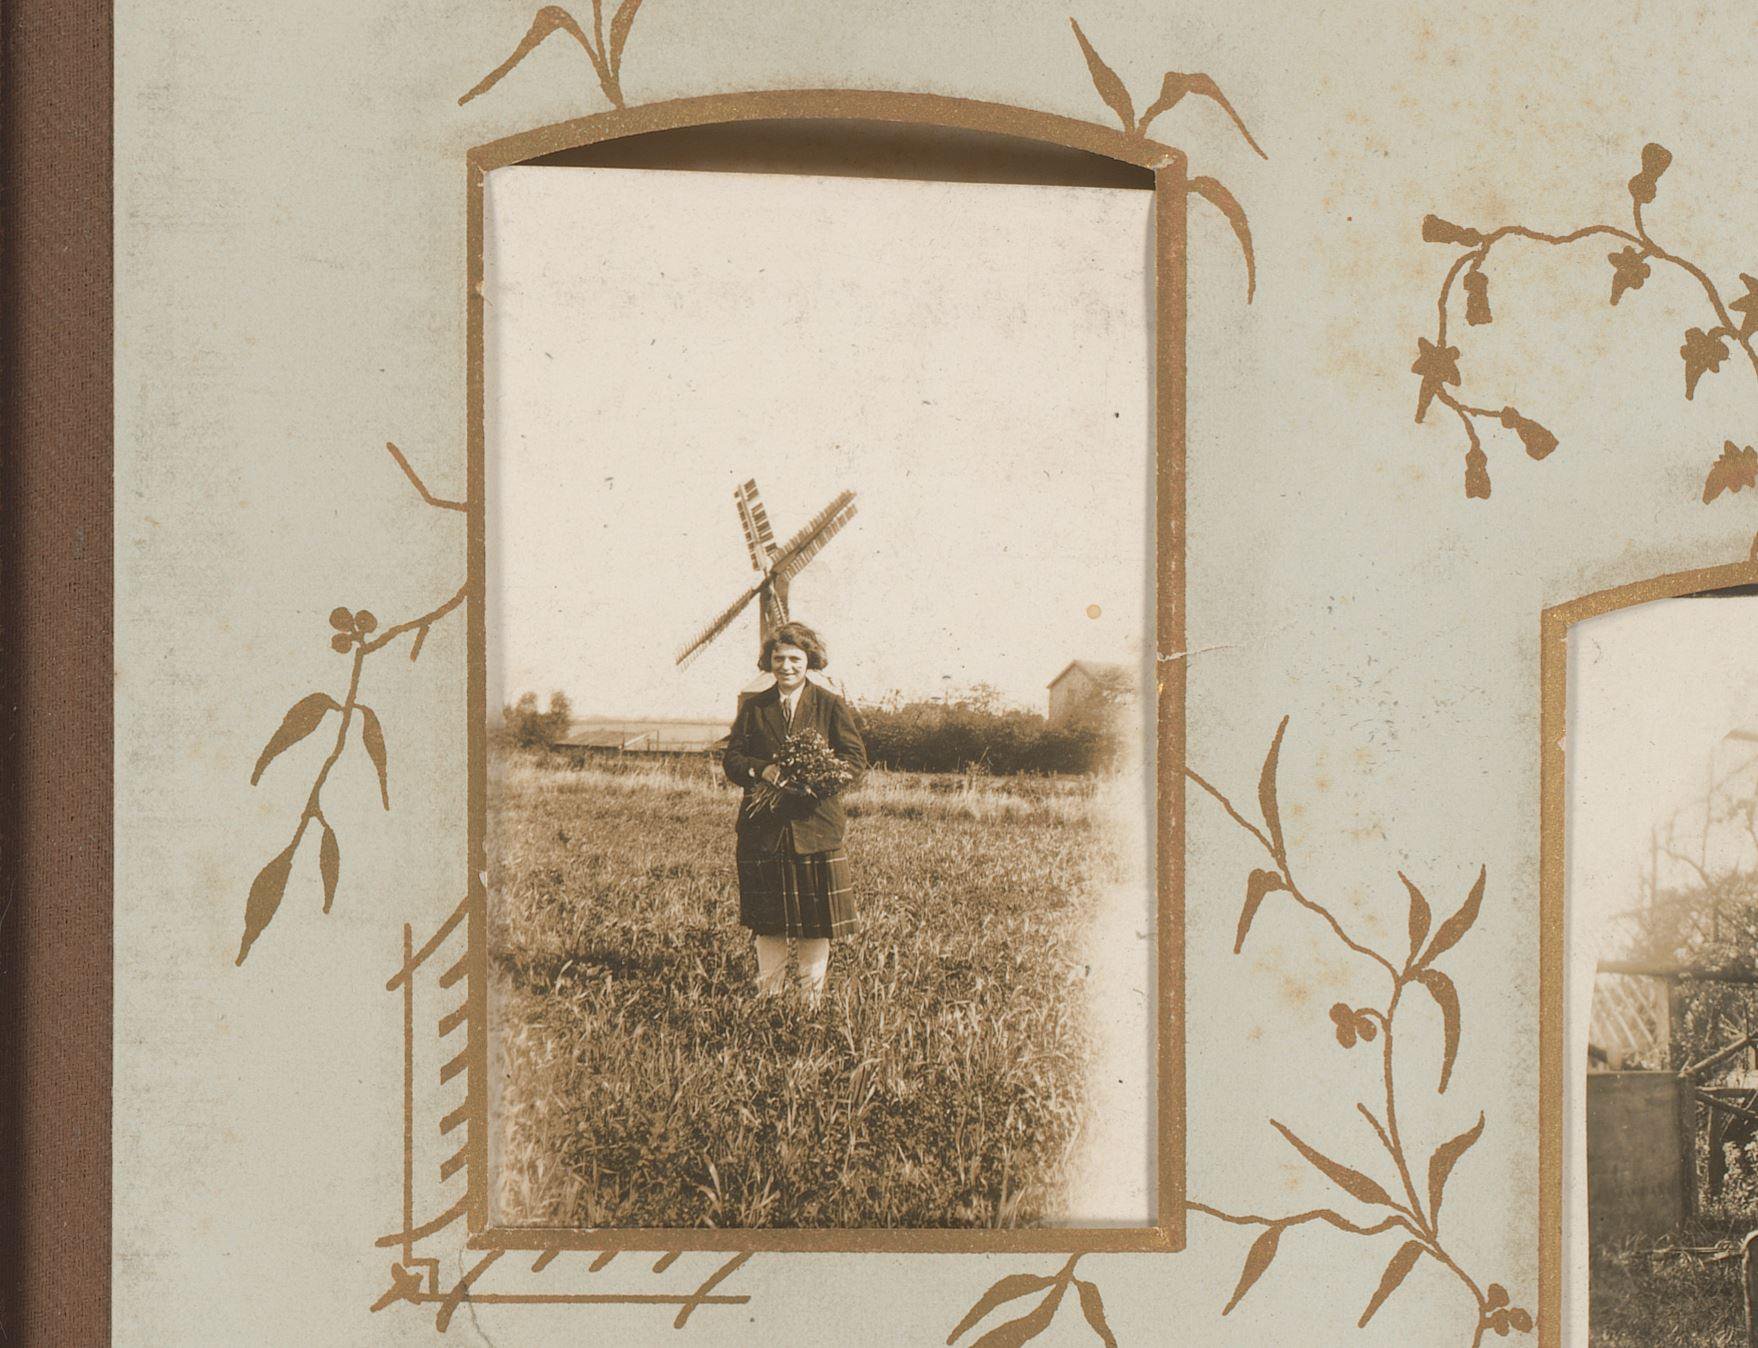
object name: photograph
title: Portret van een vrouw met bloemen voor een molen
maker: Anonymous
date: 1899-1920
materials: photographic support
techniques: gelatin silver print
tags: flowers, adult woman, historical persons, windmill